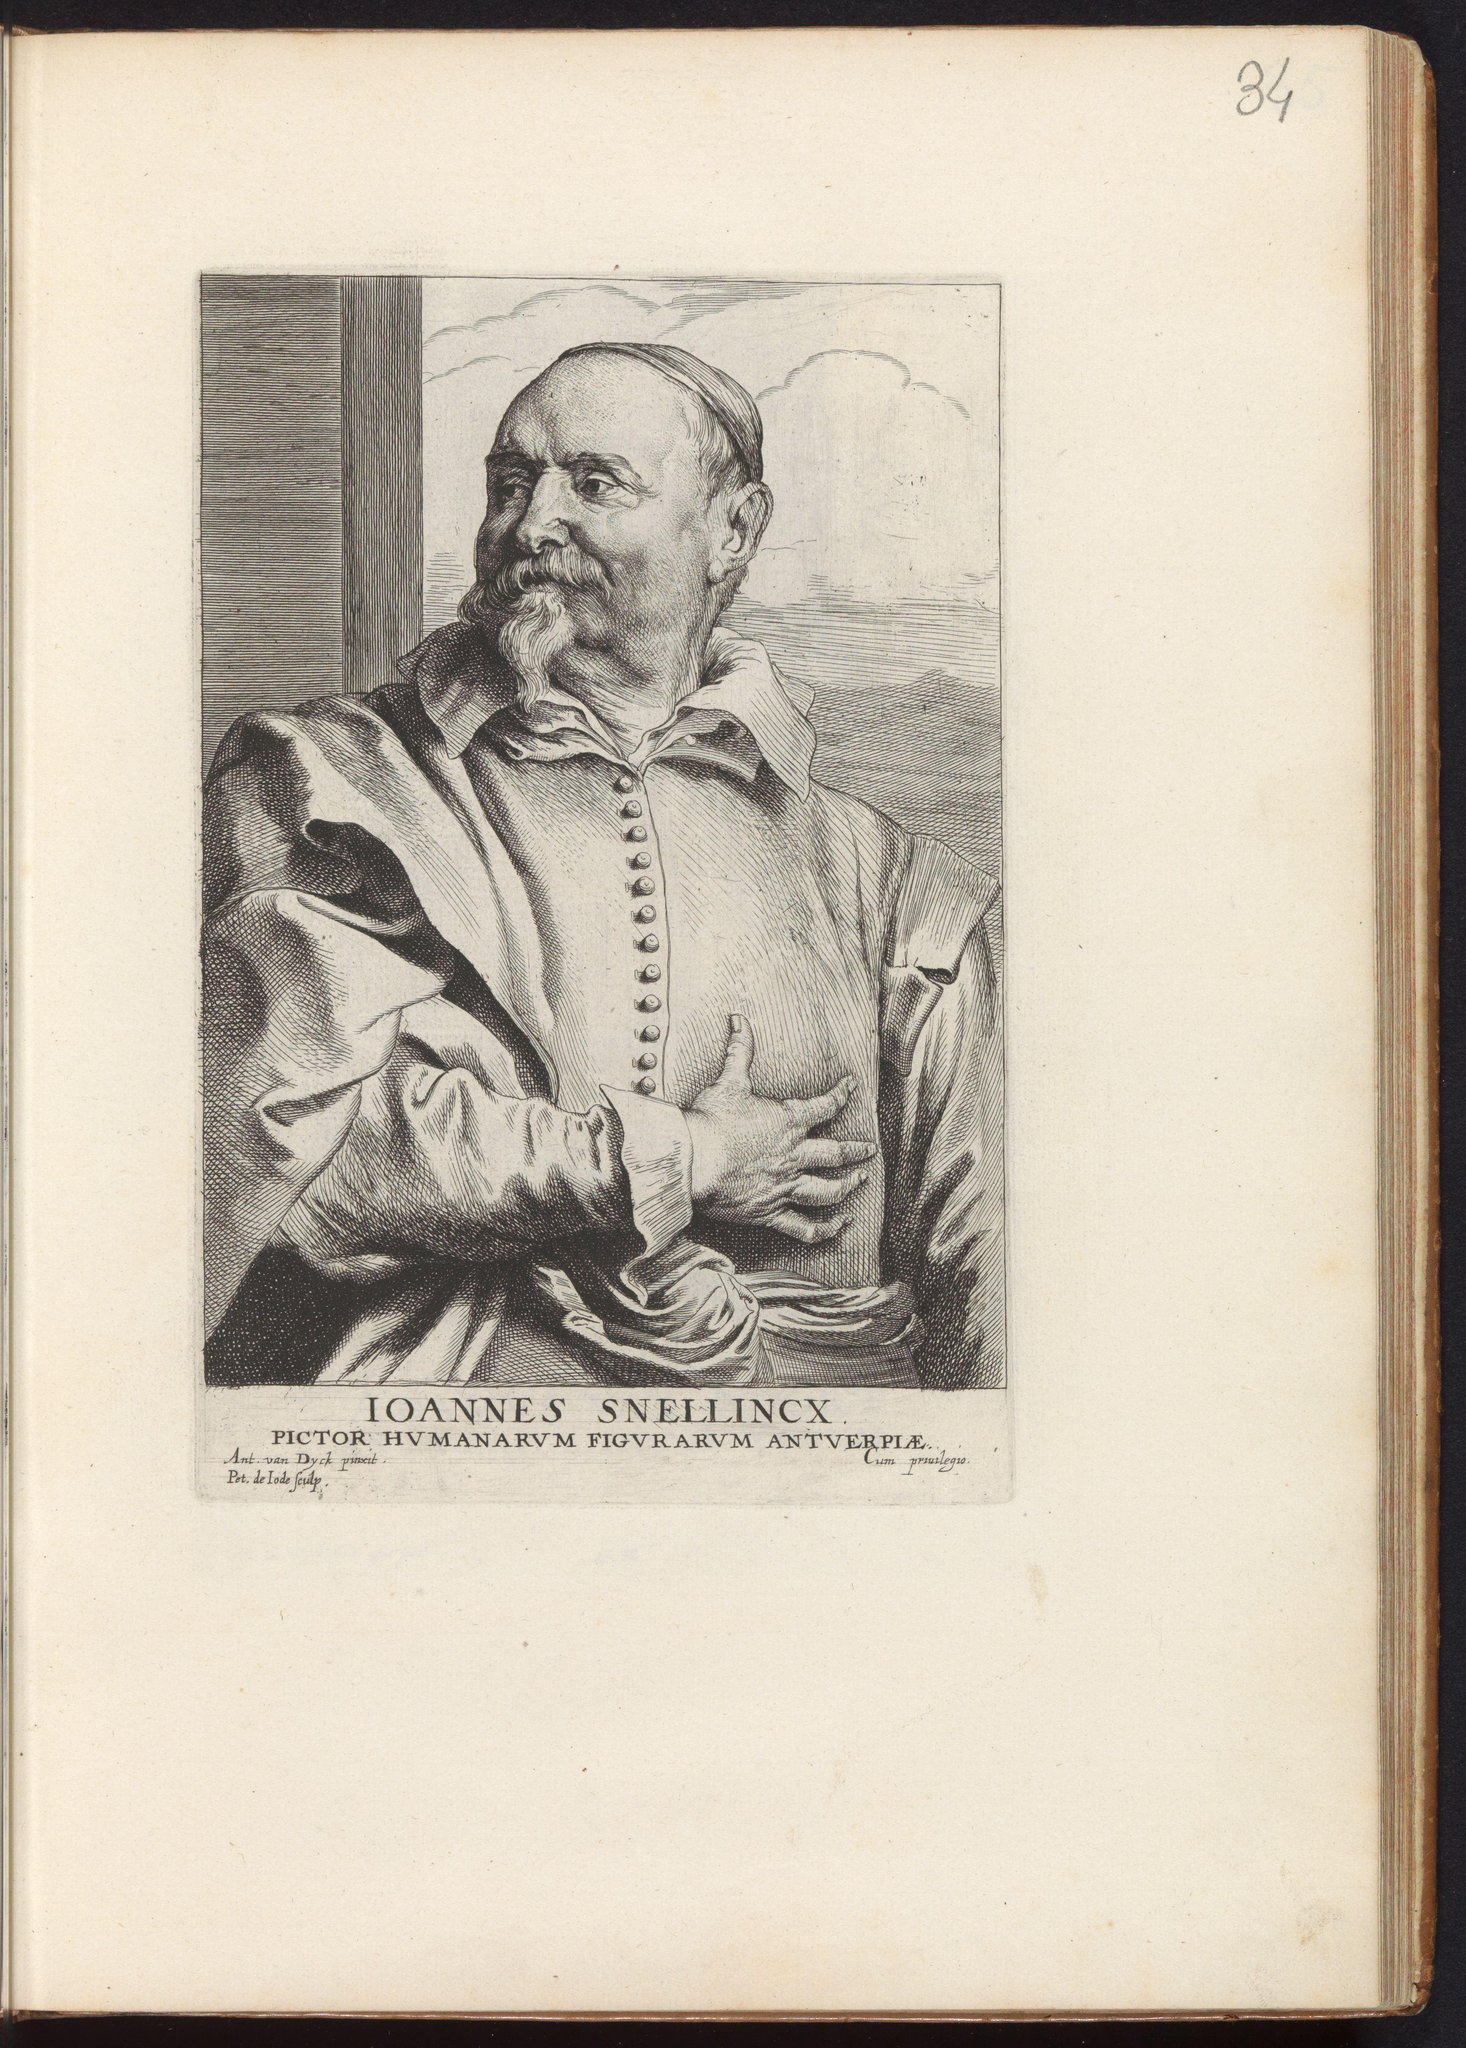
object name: print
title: Icones Principum Vivorum Doctorum Pictorum Chalcographorum Statuariorum nec non Amatorum Pictoriae Artis Numero Centum ab Antonio van Dyck Pictore ad Vivum Expressae Eiusq: Sumptibus aeri incisae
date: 1630-1641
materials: paper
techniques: engraving, etching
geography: antwerp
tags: mechelen, antwerp, painter, draughtsman, jan snellinck (i), portrait, self-portrait of artist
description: Deze prent maakt deel uit van een album.